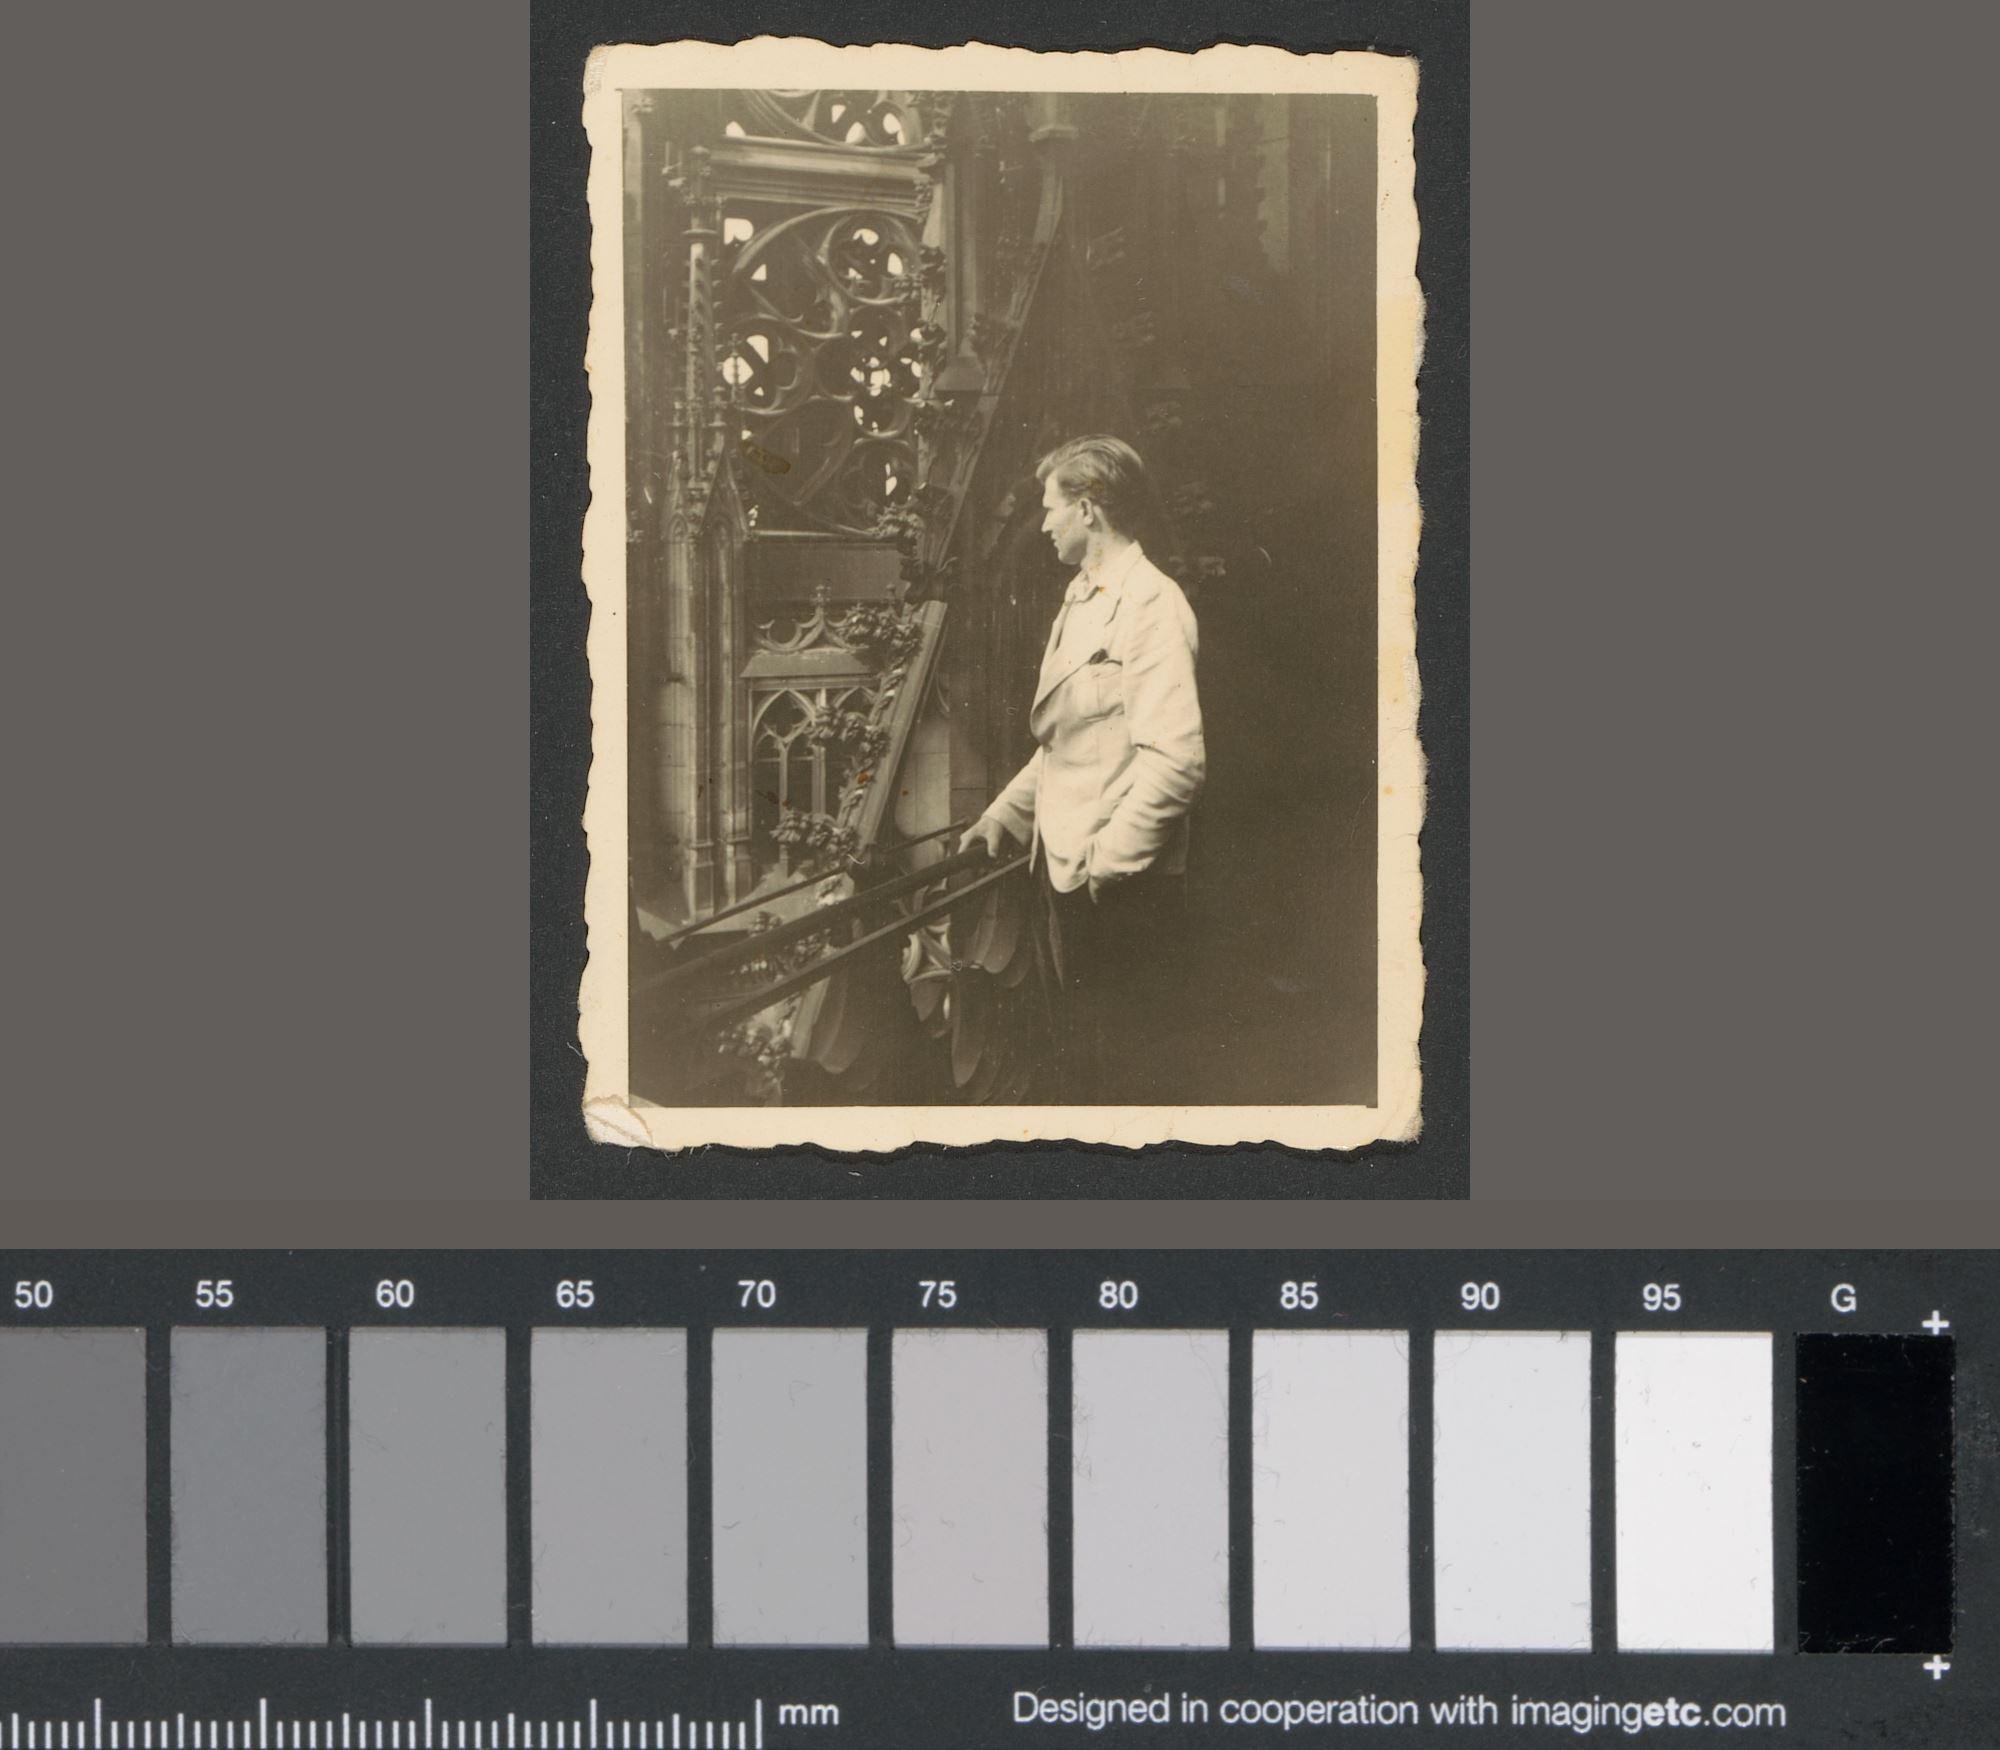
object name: photograph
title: Man bij een kerk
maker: Anonymous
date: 1930-1945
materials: paper, photographic support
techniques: gelatin silver print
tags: adult man, historical persons, church (exterior)